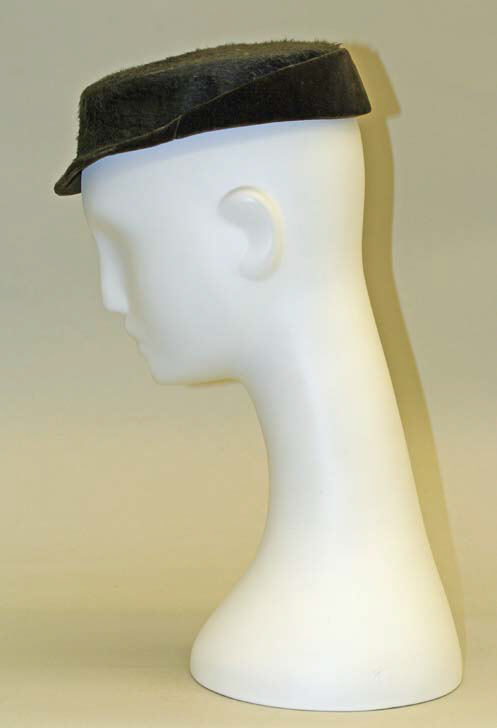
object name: hat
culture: american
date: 1865-1875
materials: cotton, silk